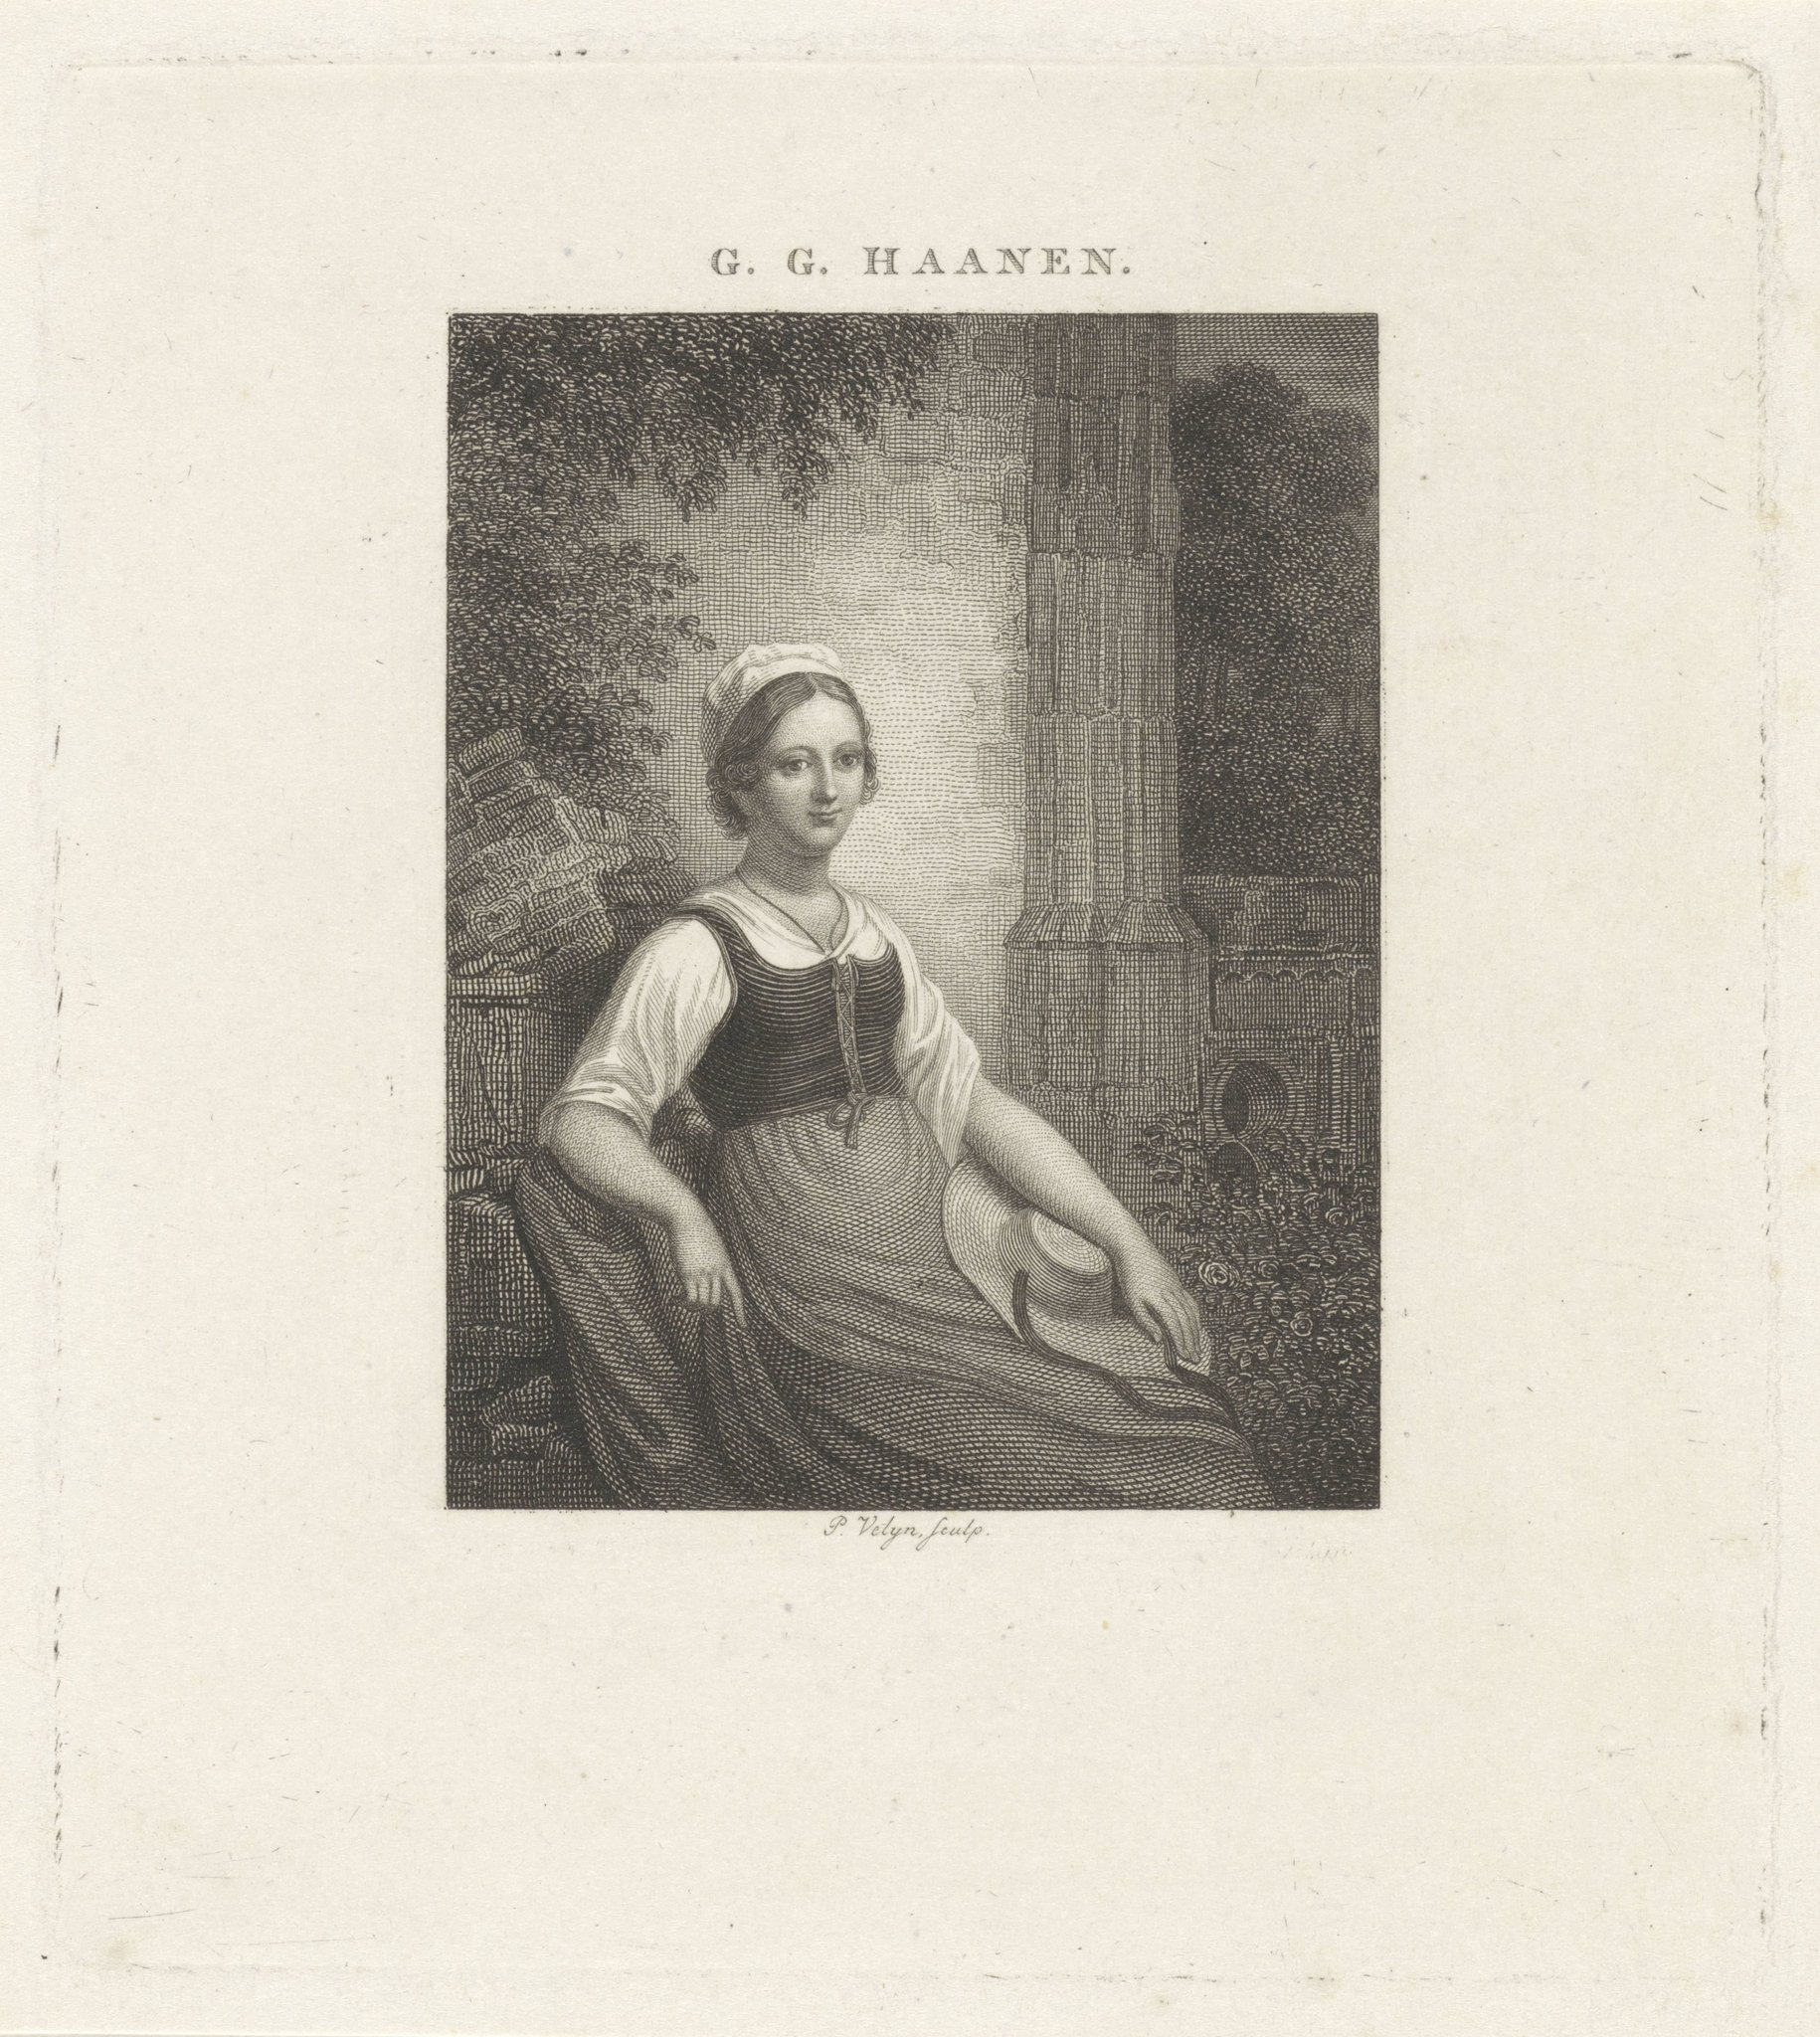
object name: print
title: Zittende jonge vrouw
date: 1817-1836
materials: paper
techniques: etching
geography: netherlands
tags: adolescent, young woman, maiden, head-gear: hat (+ women's clothes)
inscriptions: collector's mark: Lugt 2228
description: Een zittende jonge vrouw, onder haar rechterarm een platte strooien hoed.